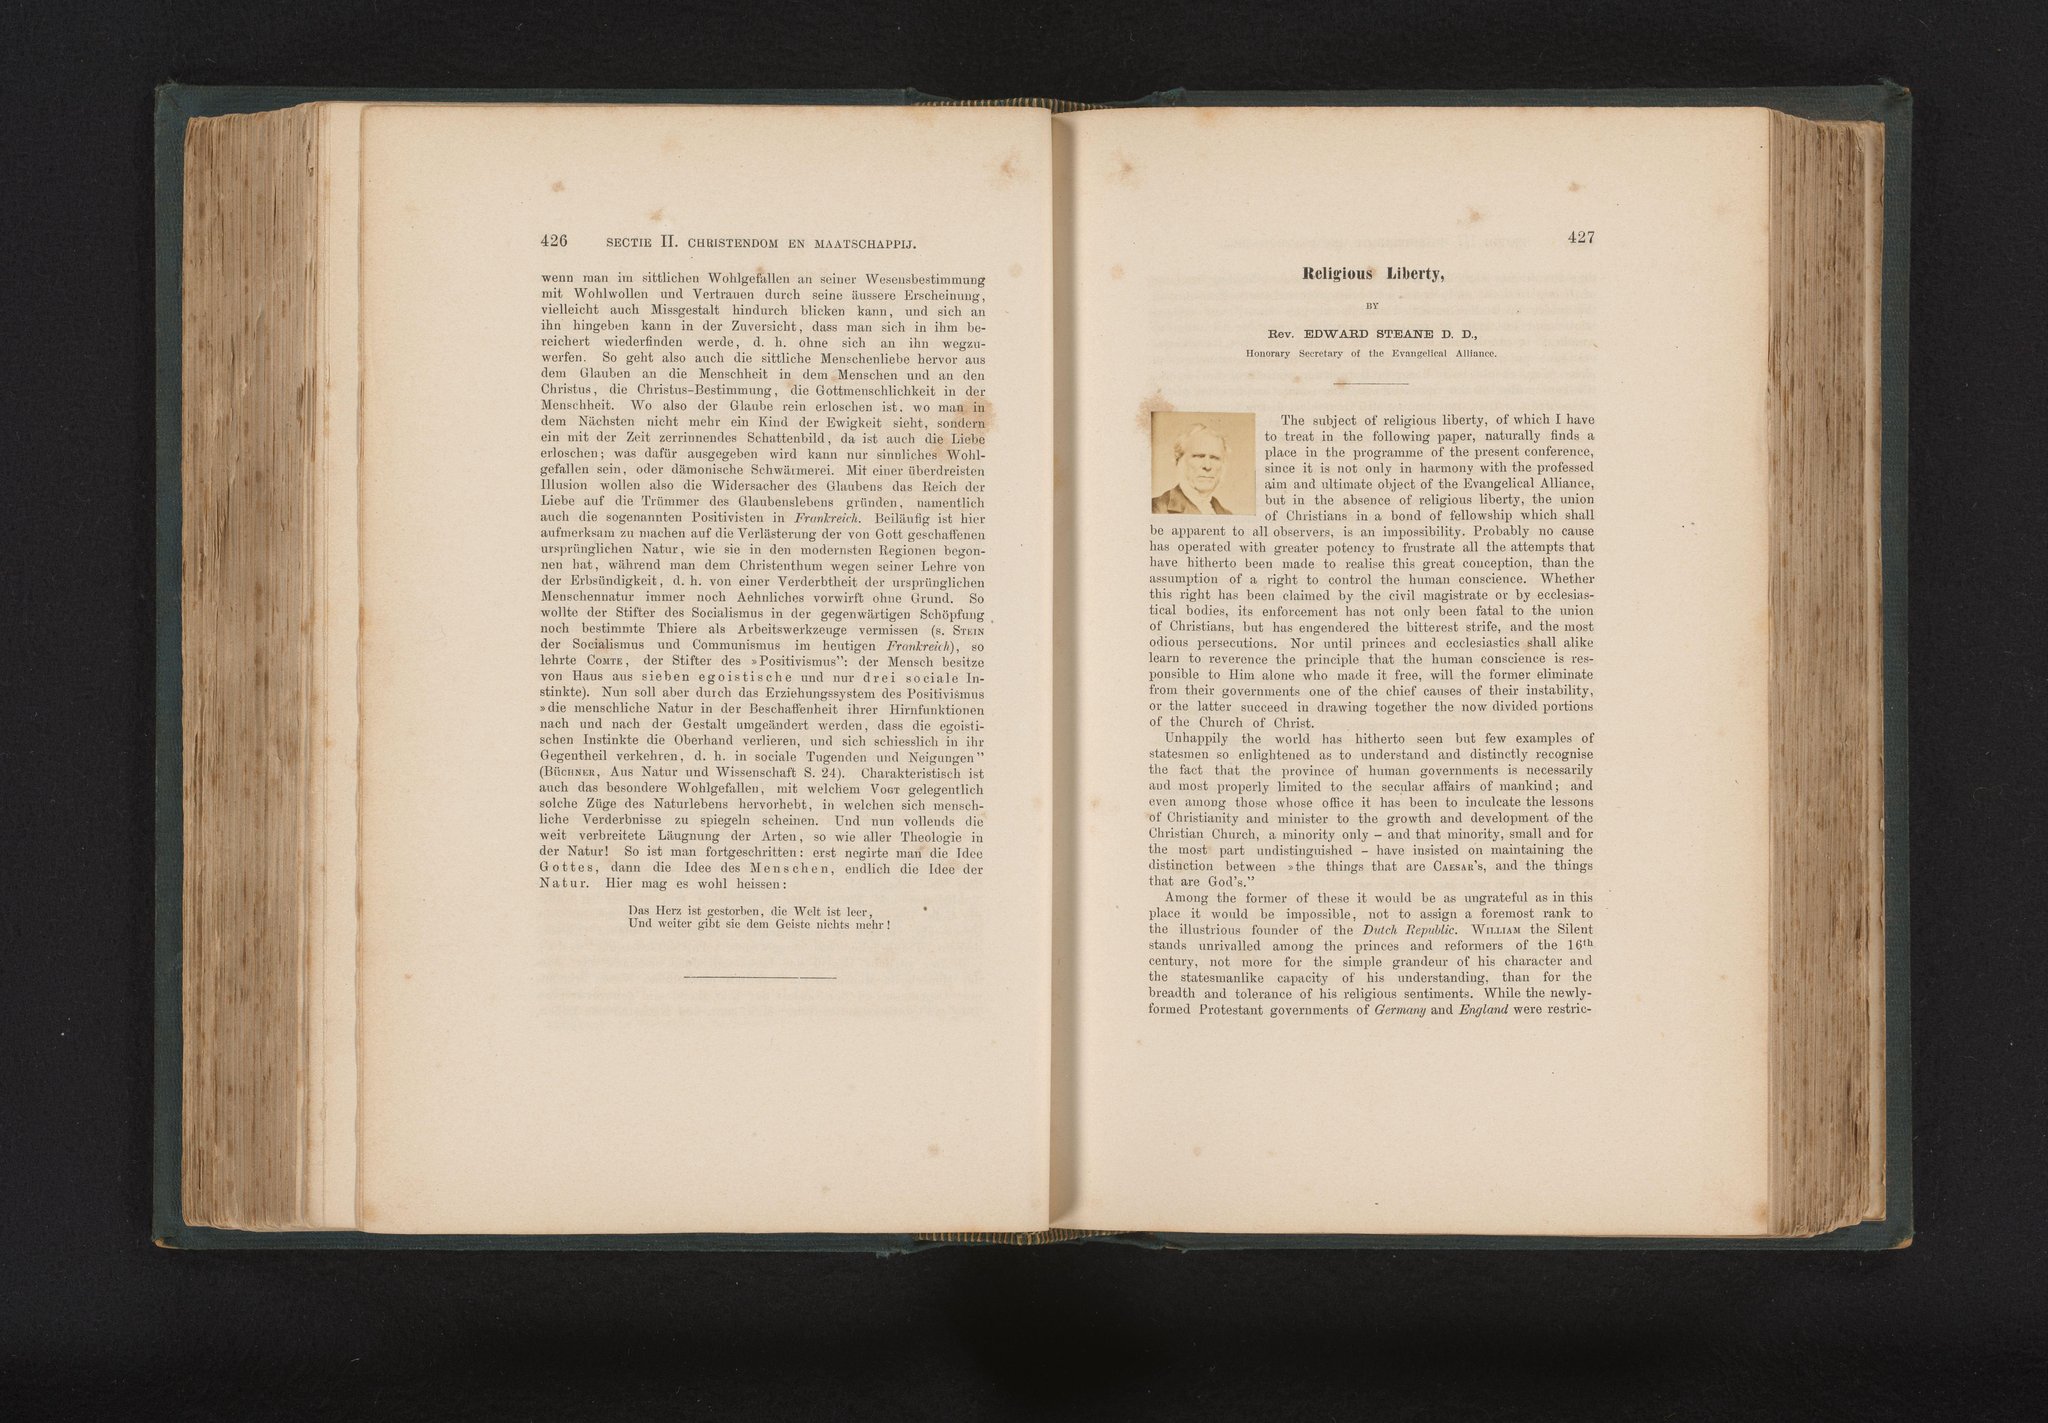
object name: photograph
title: Portret van Edward Steane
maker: Anonymous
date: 1855-1867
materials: paper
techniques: albumen print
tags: historical persons